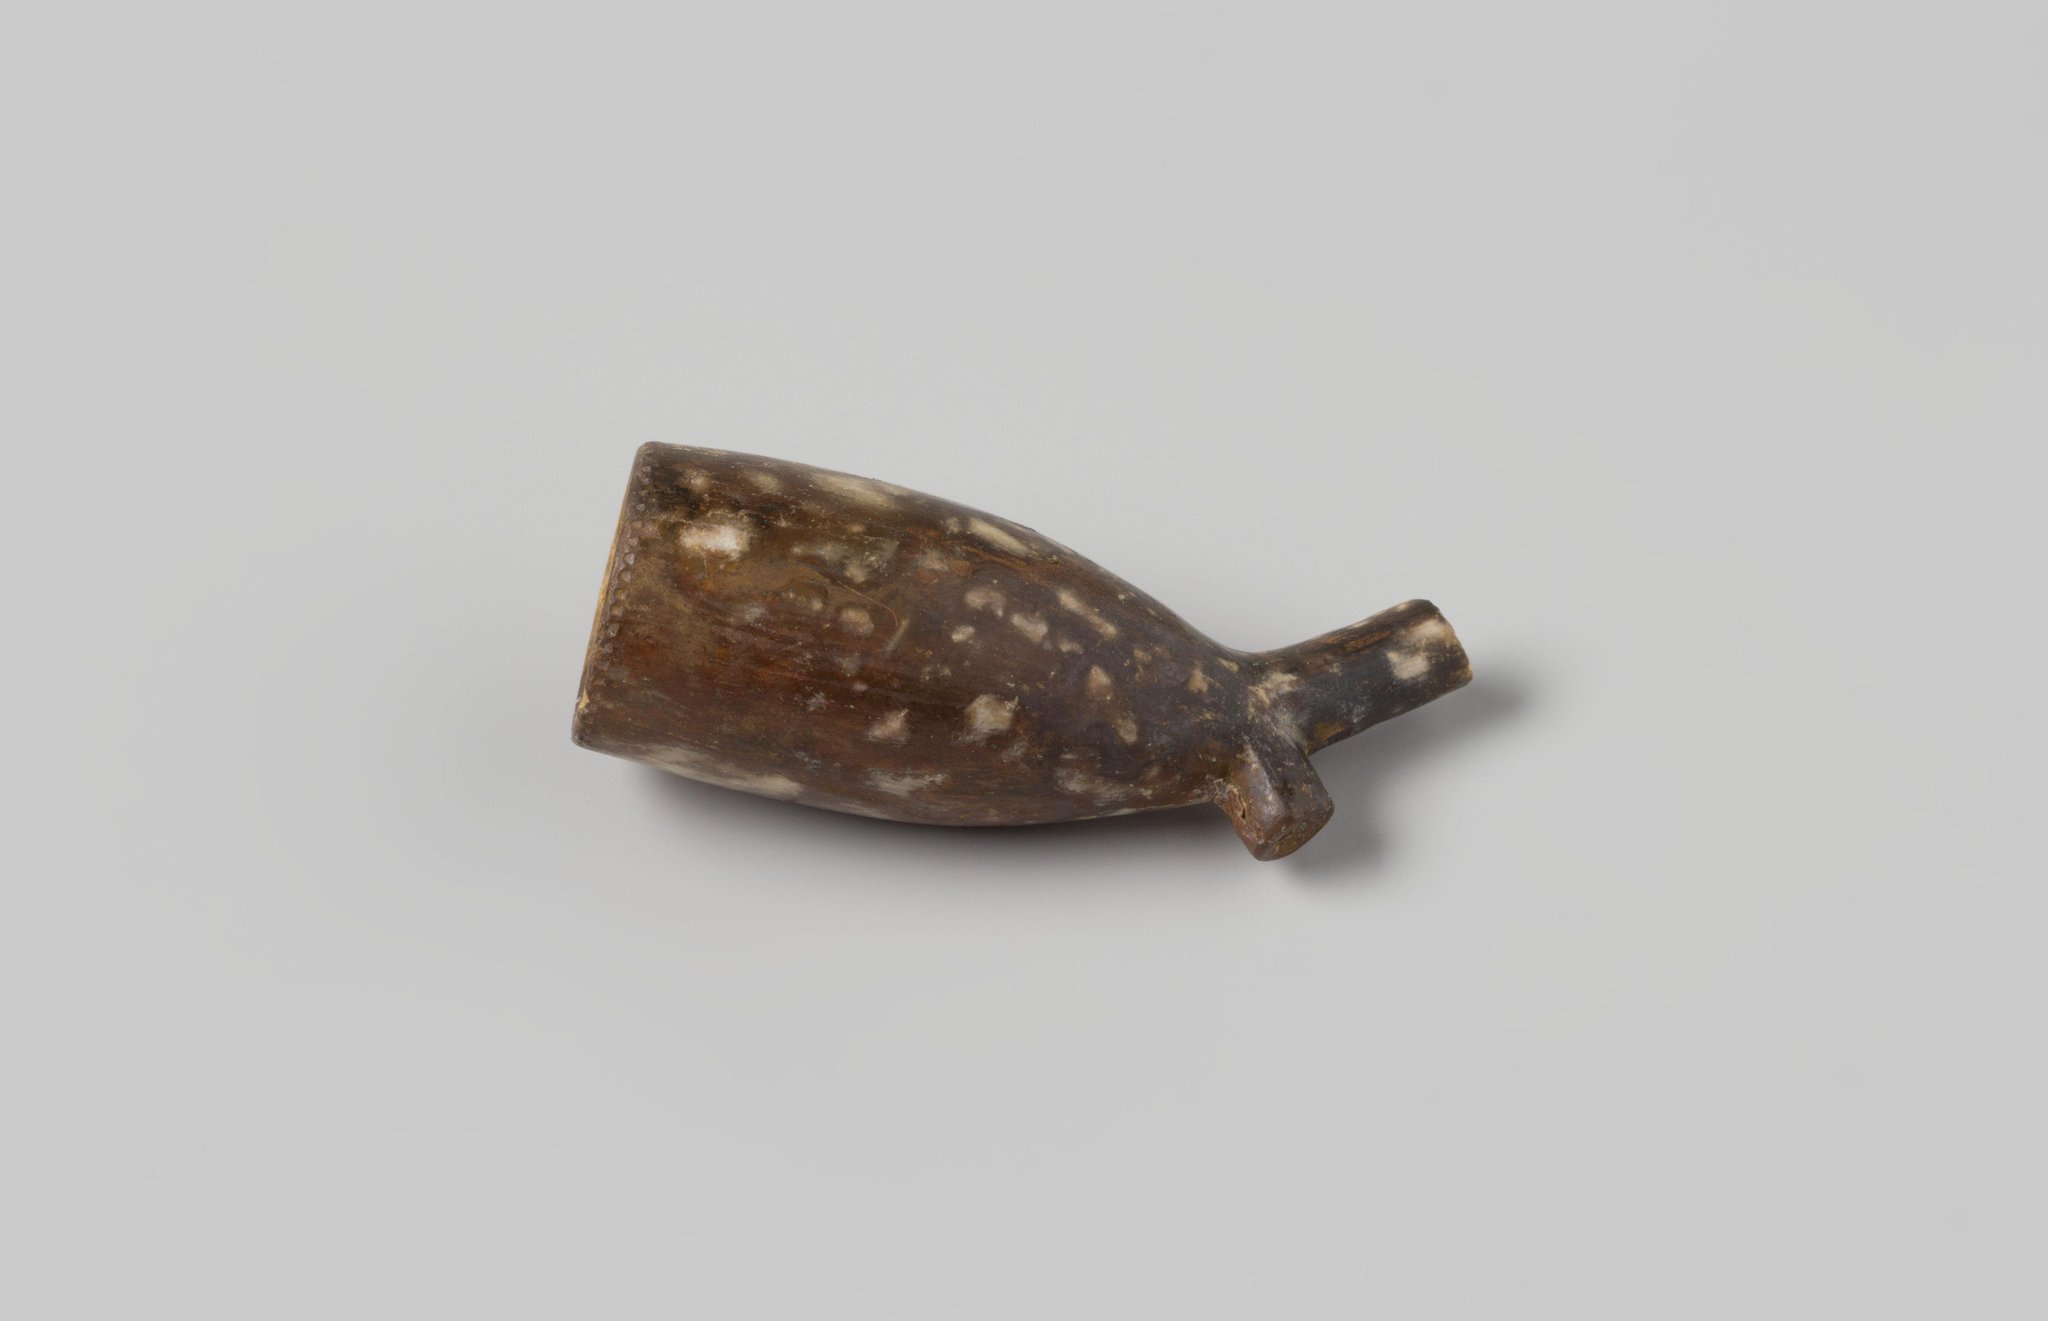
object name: pipe bowl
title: Pijpenkop met stuk steel uit het wrak van de Oost-Indiëvaarder Hollandia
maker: Anonymous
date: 1700-1743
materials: clay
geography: netherlands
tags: verenigde oostindische compagnie, hollandia (schip), annet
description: Pipe, bowl, heelmark: tobacco's brazier; no hsm.